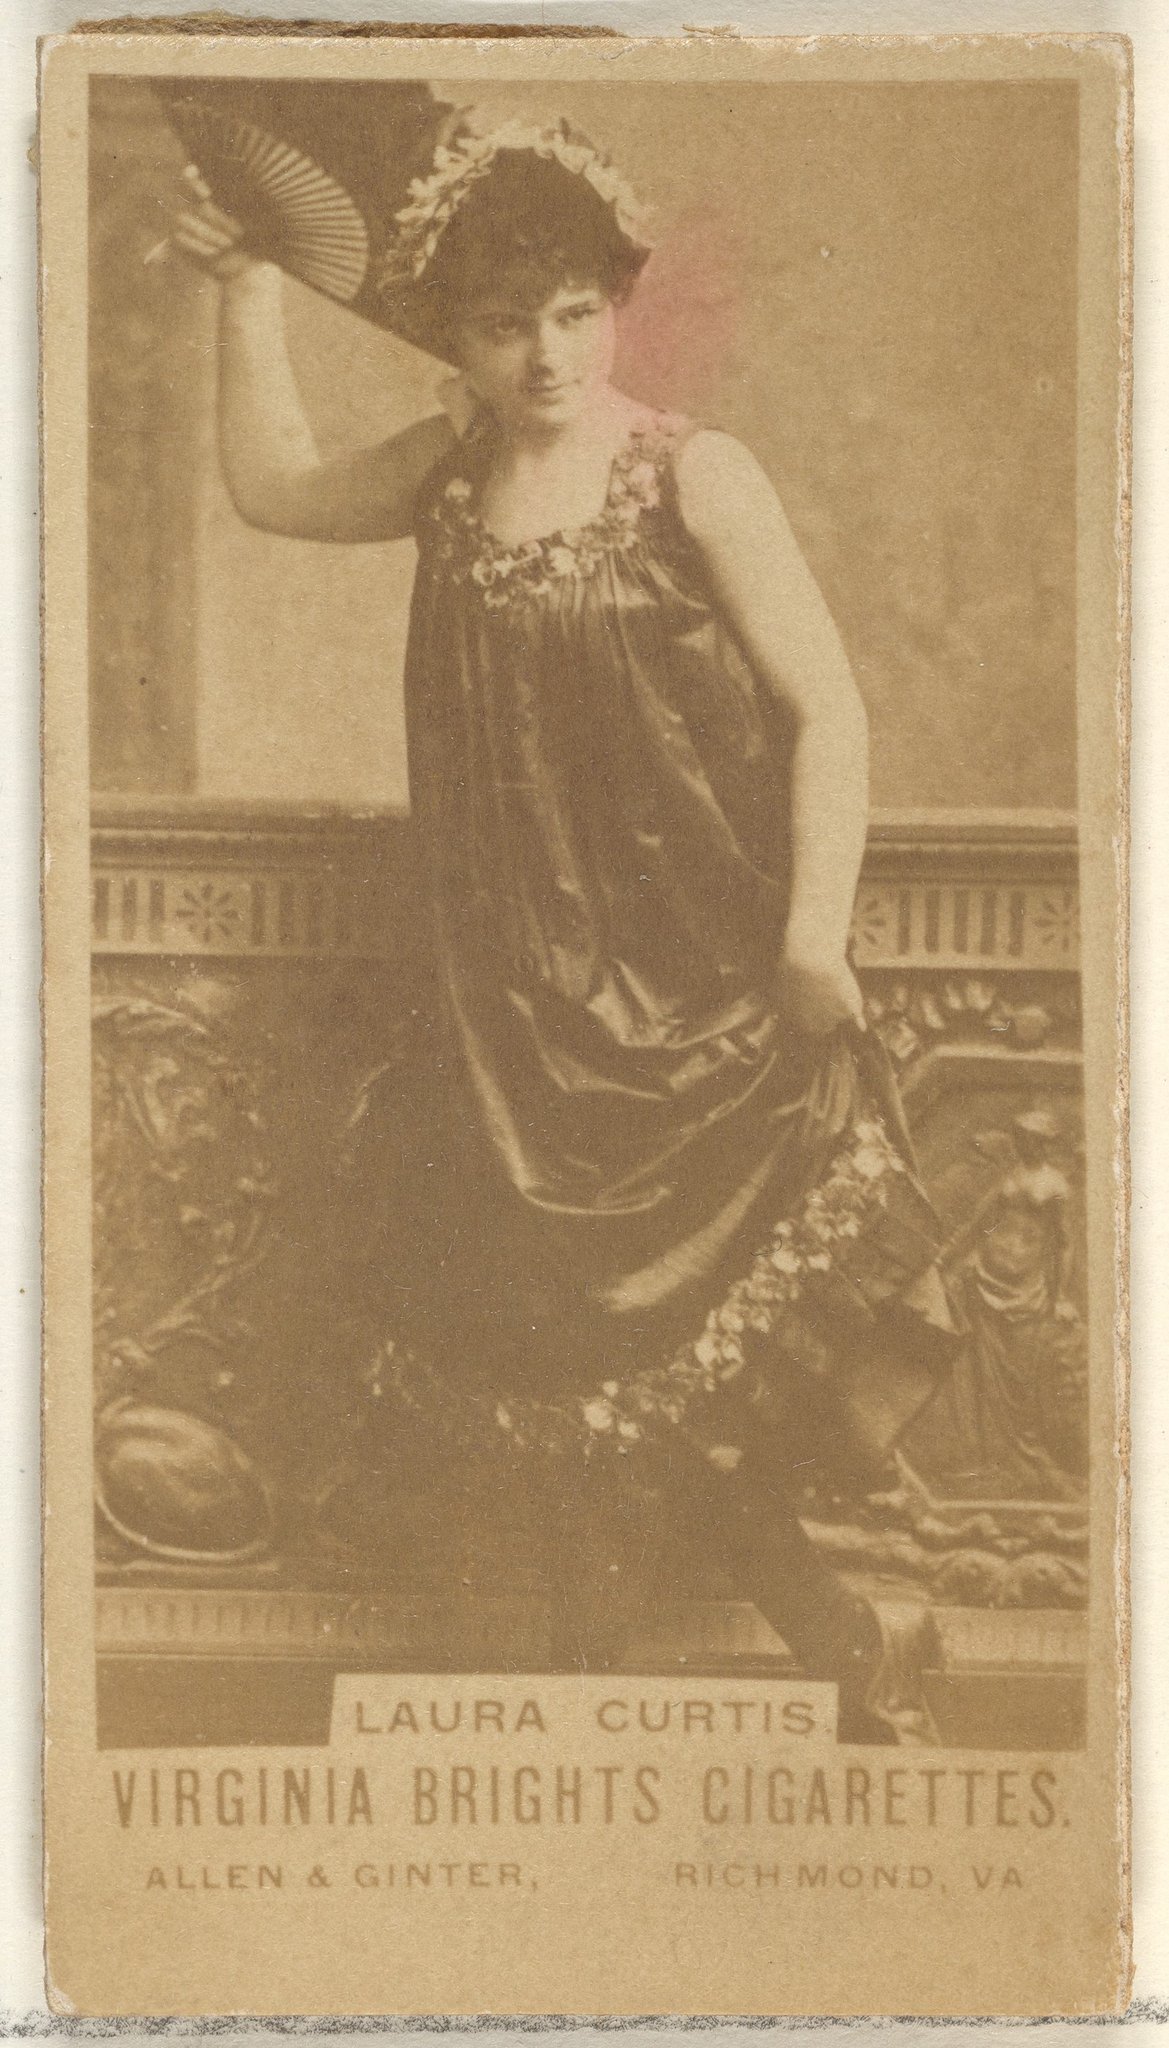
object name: photograph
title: Laura Curtis, from the Actors and Actresses series (N45, Type 1) for Virginia Brights Cigarettes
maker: allen & ginter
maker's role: publisher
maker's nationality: american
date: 1888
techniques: albumen silver print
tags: fans,portraits,women,actresses